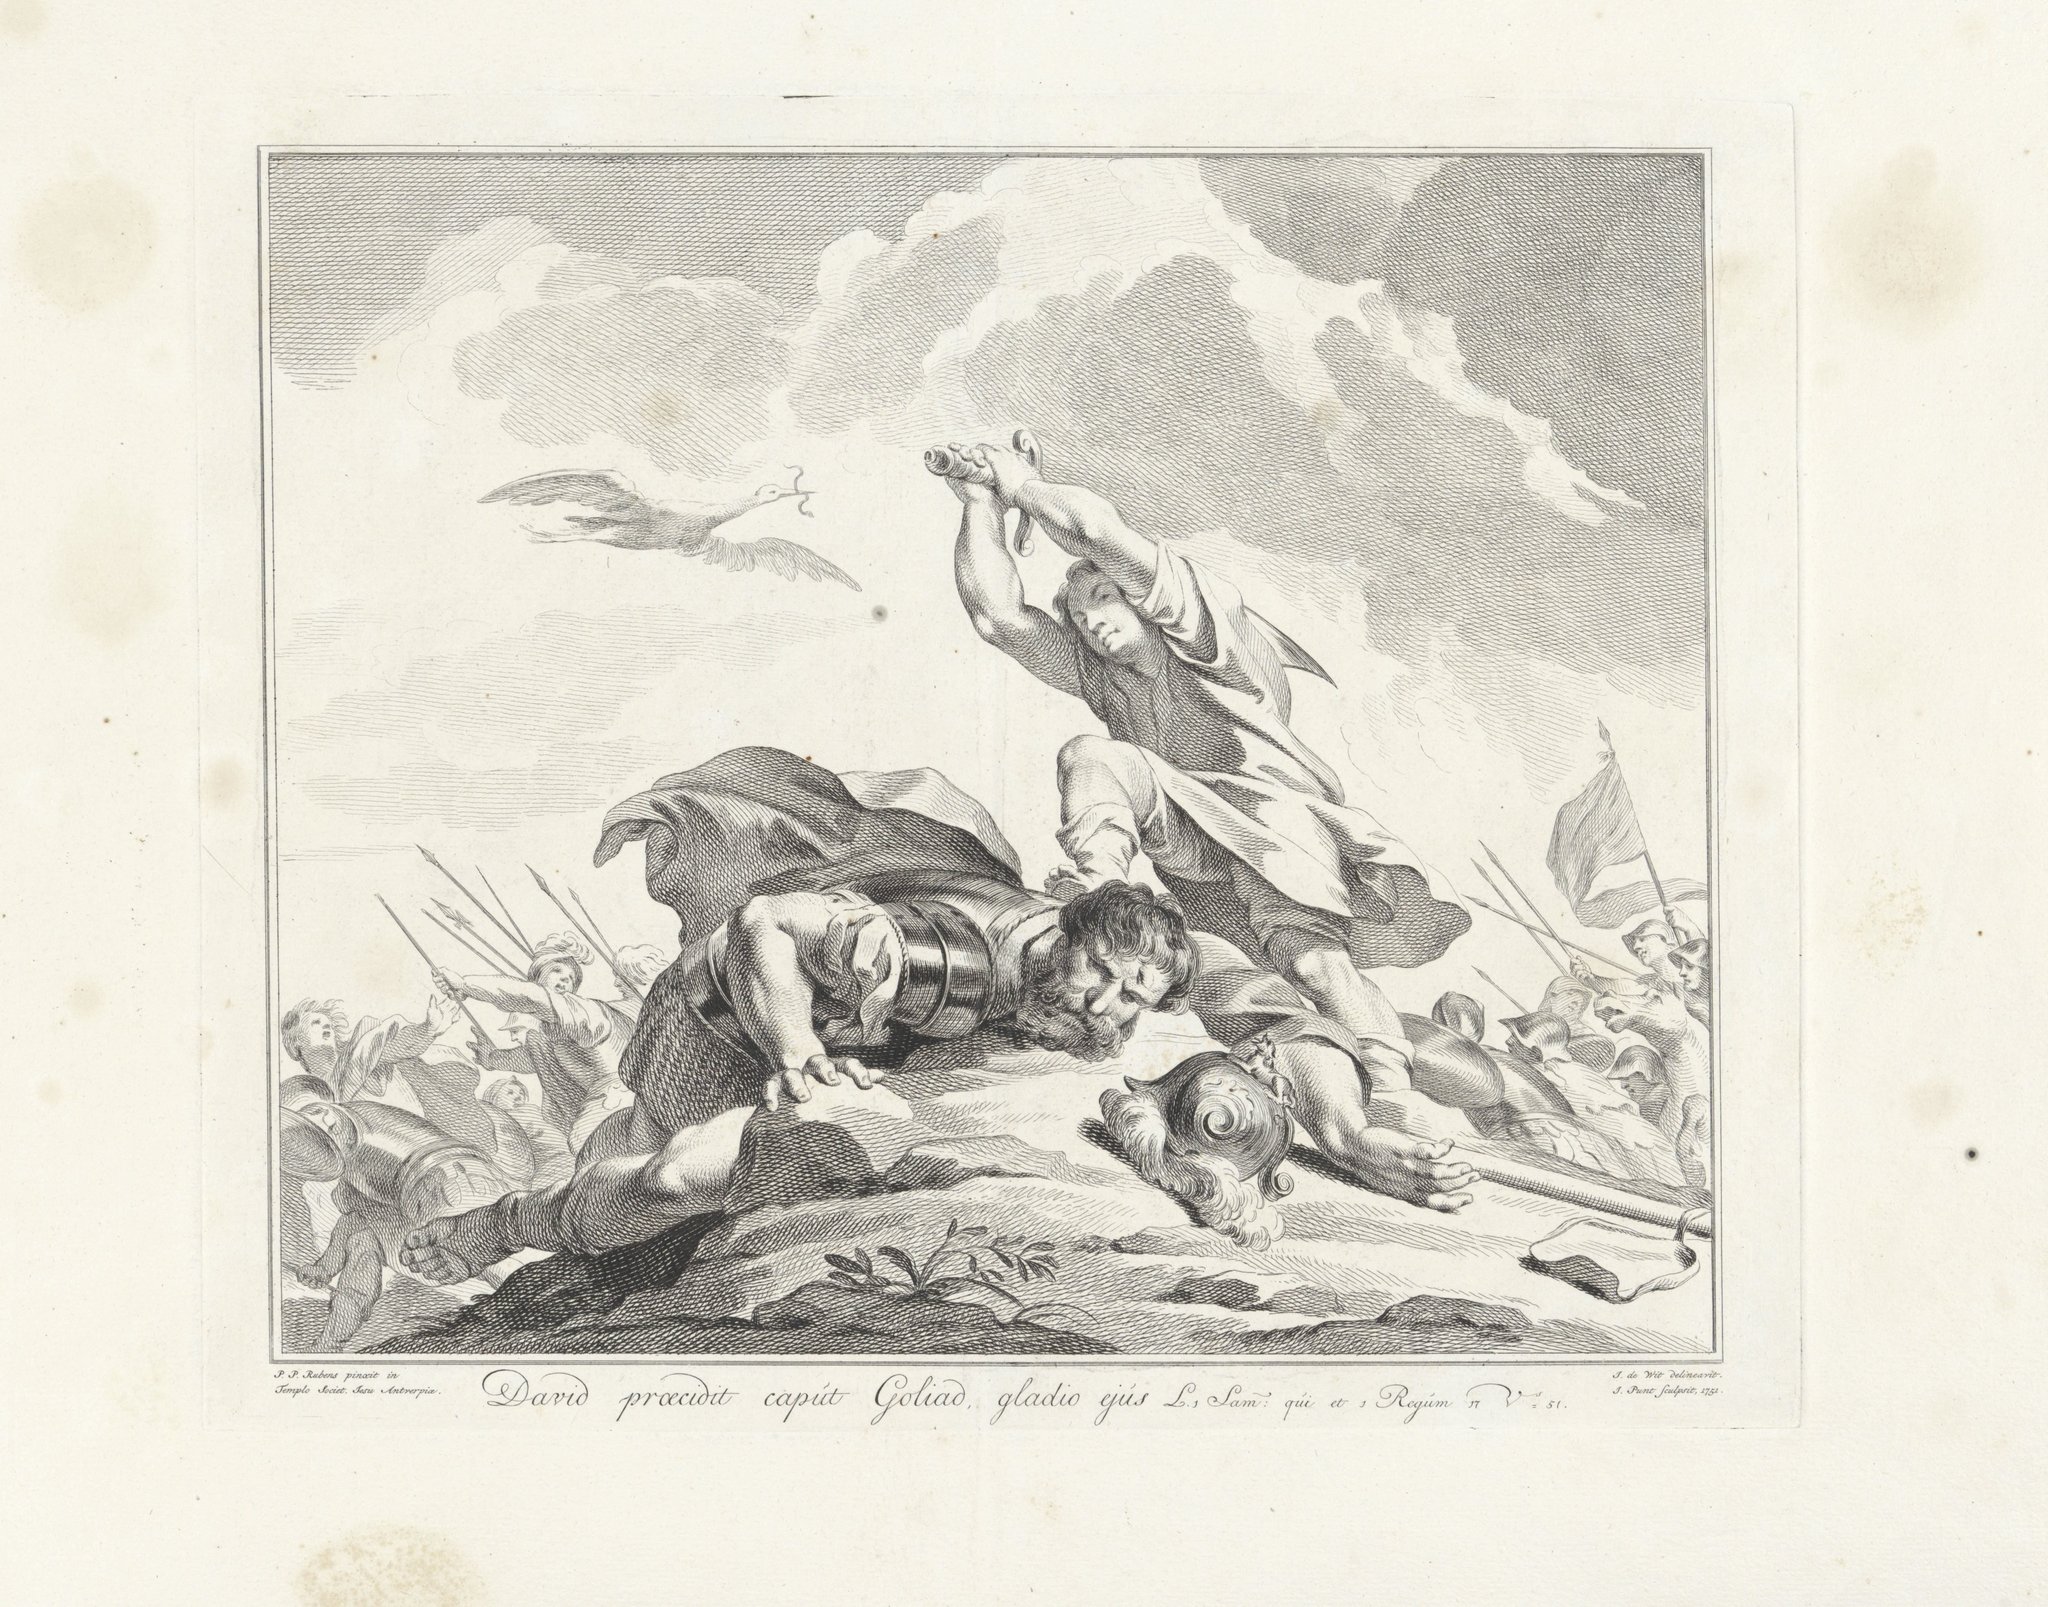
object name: print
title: David onthoofdt Goliat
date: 1752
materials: paper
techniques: engraving, etching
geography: amsterdam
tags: david beheads goliath with a sword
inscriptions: date: ‘1752’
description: Goliat ligt op de grond en David staat op het punt zijn hoofd af te houwen. Onder de rechthoekige voorstelling een vers in het Latijn uit 1 Sam. 17:51.